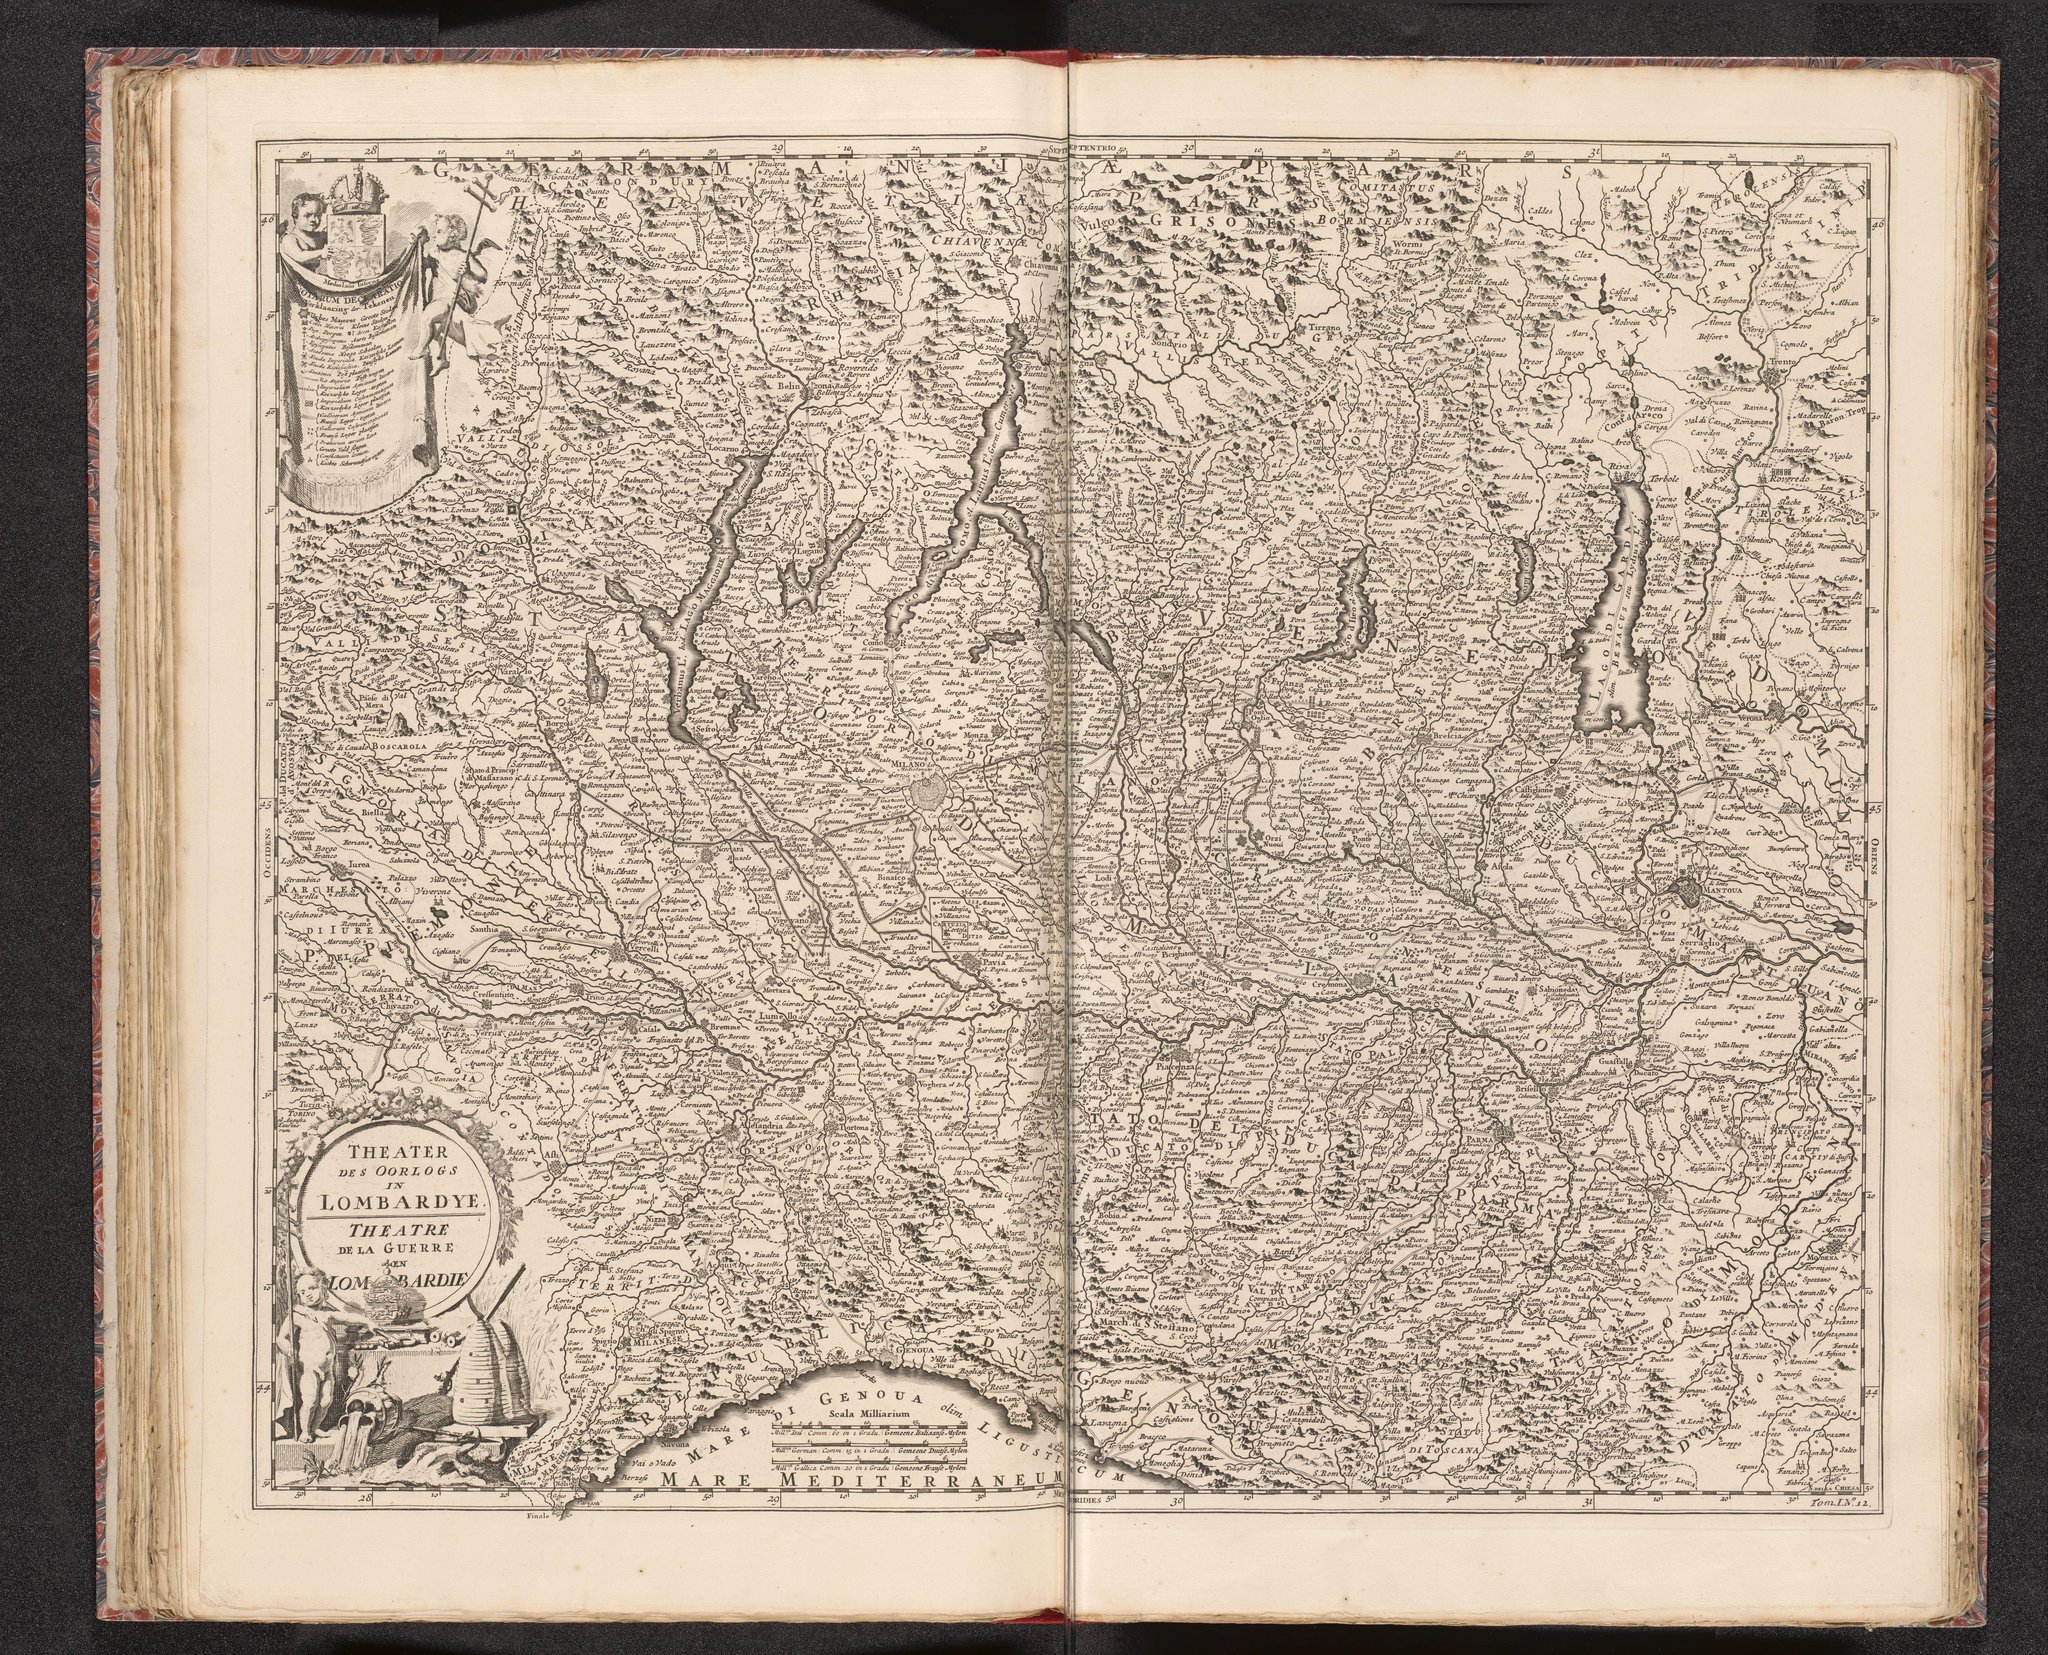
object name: print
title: Theater des Oorlogs in Lombardye / Theatre de la Guerre en Lombardie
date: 1701-1713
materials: paper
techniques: engraving, etching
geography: northern netherlands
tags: paris, vienna, eugenius van savoye, maps of separate countries or regions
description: Kaart van het strijdtoneel van de Spaanse Successieoorlog in Lombardije, 1701-1713. Genummerd rechtsonder: Tom. I. No. 12. Illustratie in het eerste deel van: Jean du Mont, Oorlogskundige beschryving van de veldslagen en belegeringen, der drie ... wydvermaarde krygsoversten... den Prins Eugenius van Savoye, den ... Hertog van Marlborough, en den Prins van Oranje en Nassau-Vriesland, in de editie van 1729. Dit eerste deel is gewijd aan de daden van Eugenius, prins van Savoye.